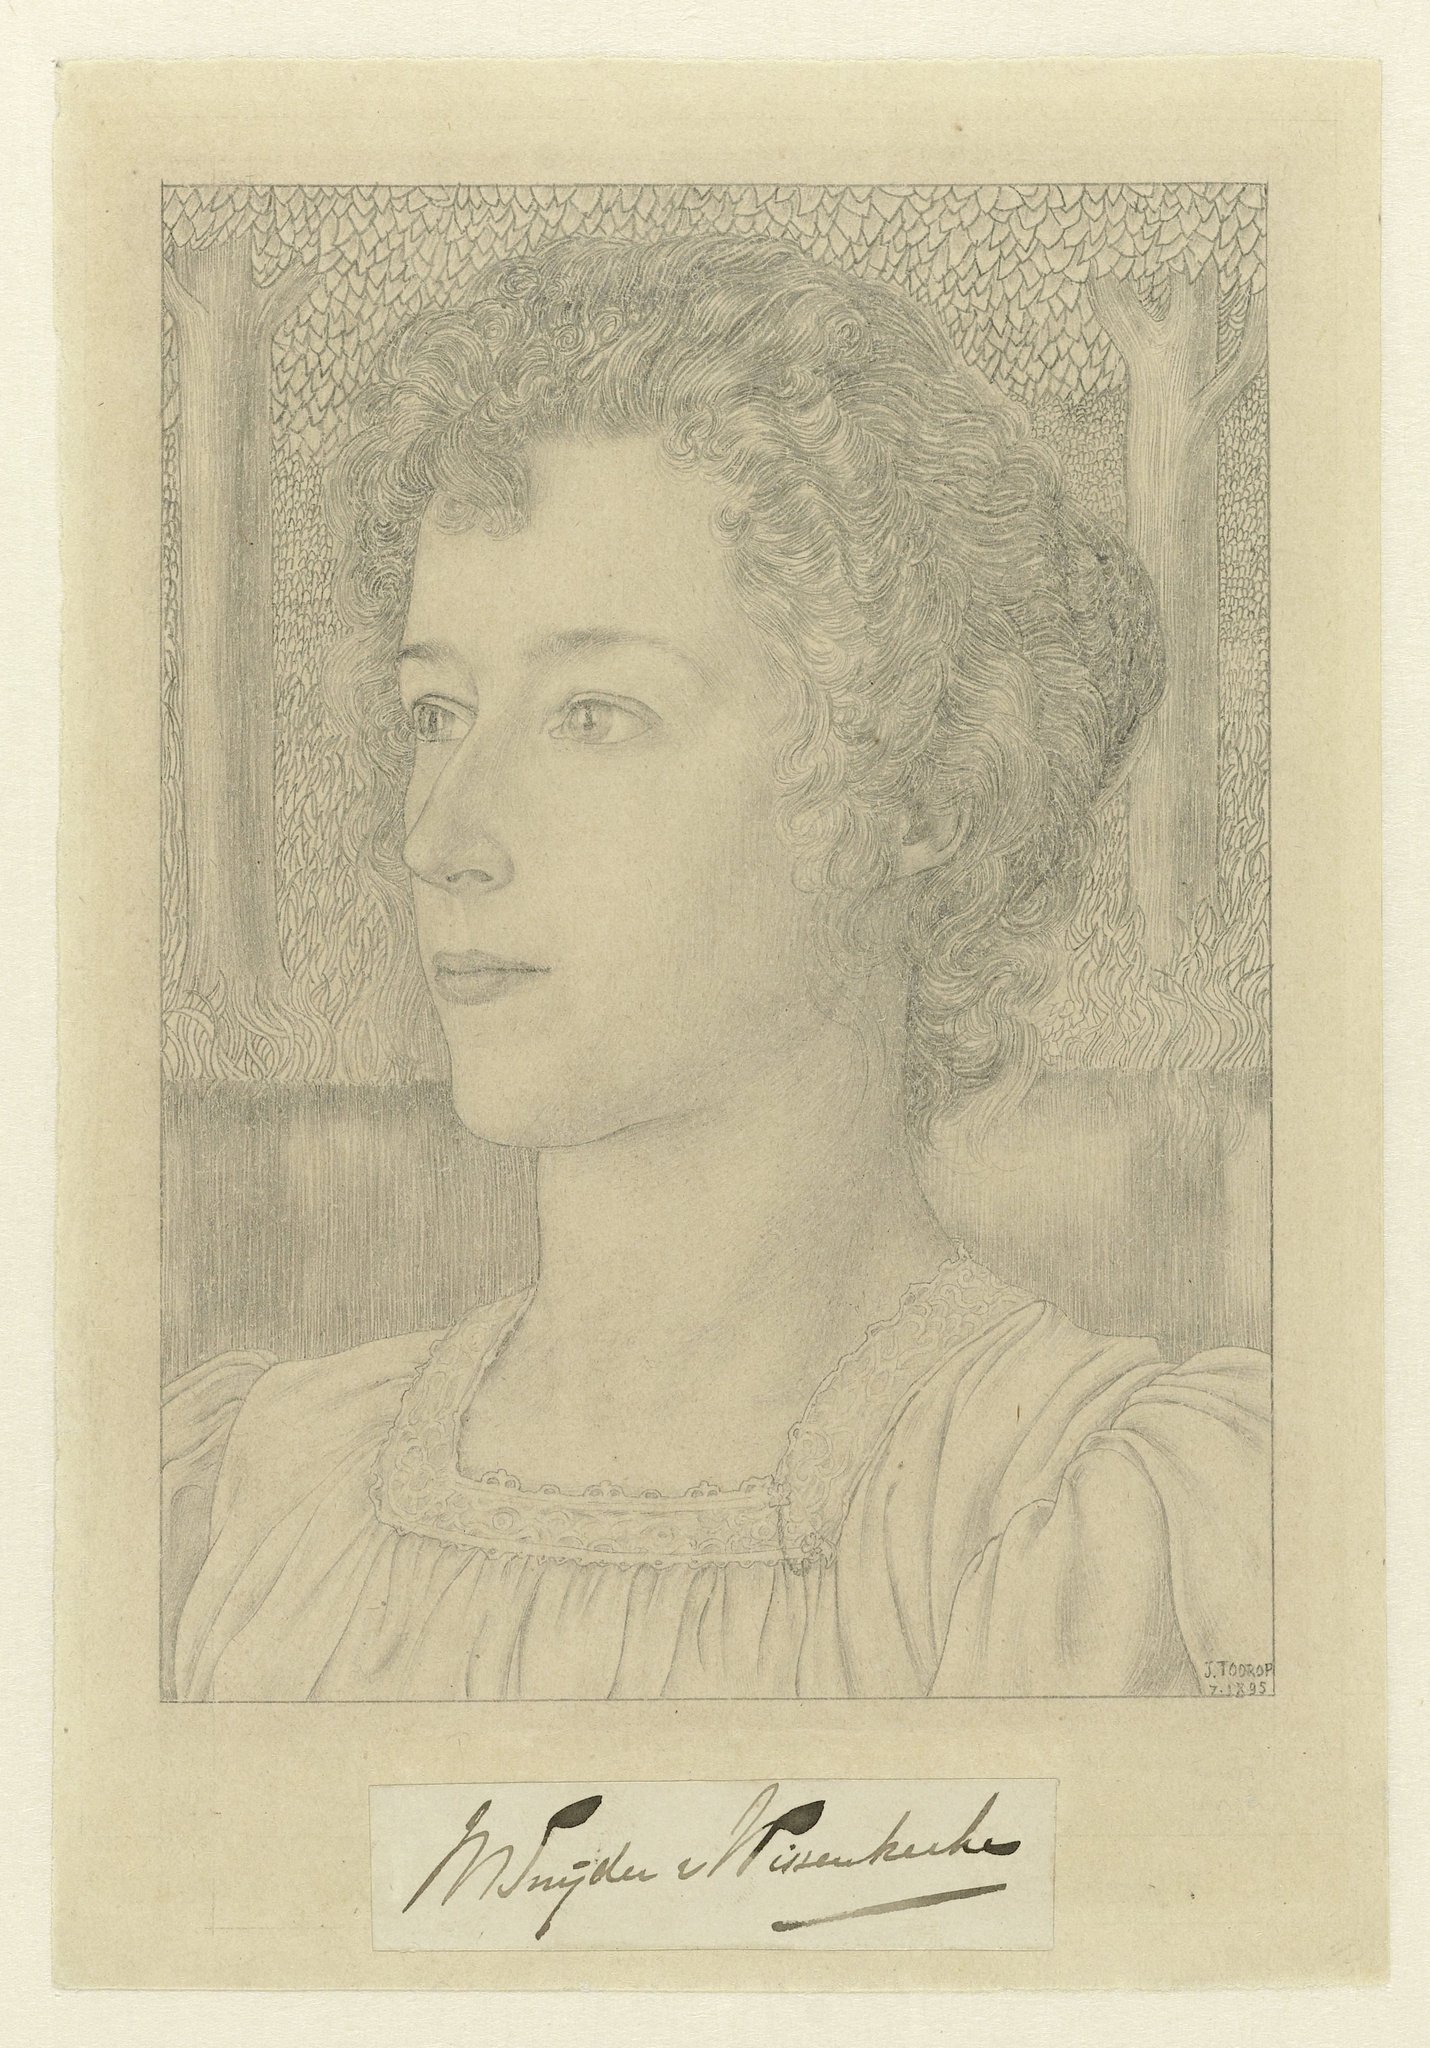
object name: drawing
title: Portret van mejuffrouw M. Snijder van Wissenkerke met op de achtergrond een weide met bomen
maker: jan toorop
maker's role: draughtsman, painter, print maker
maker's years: 1858-1928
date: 1807-1895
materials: paper, pencil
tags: historical persons